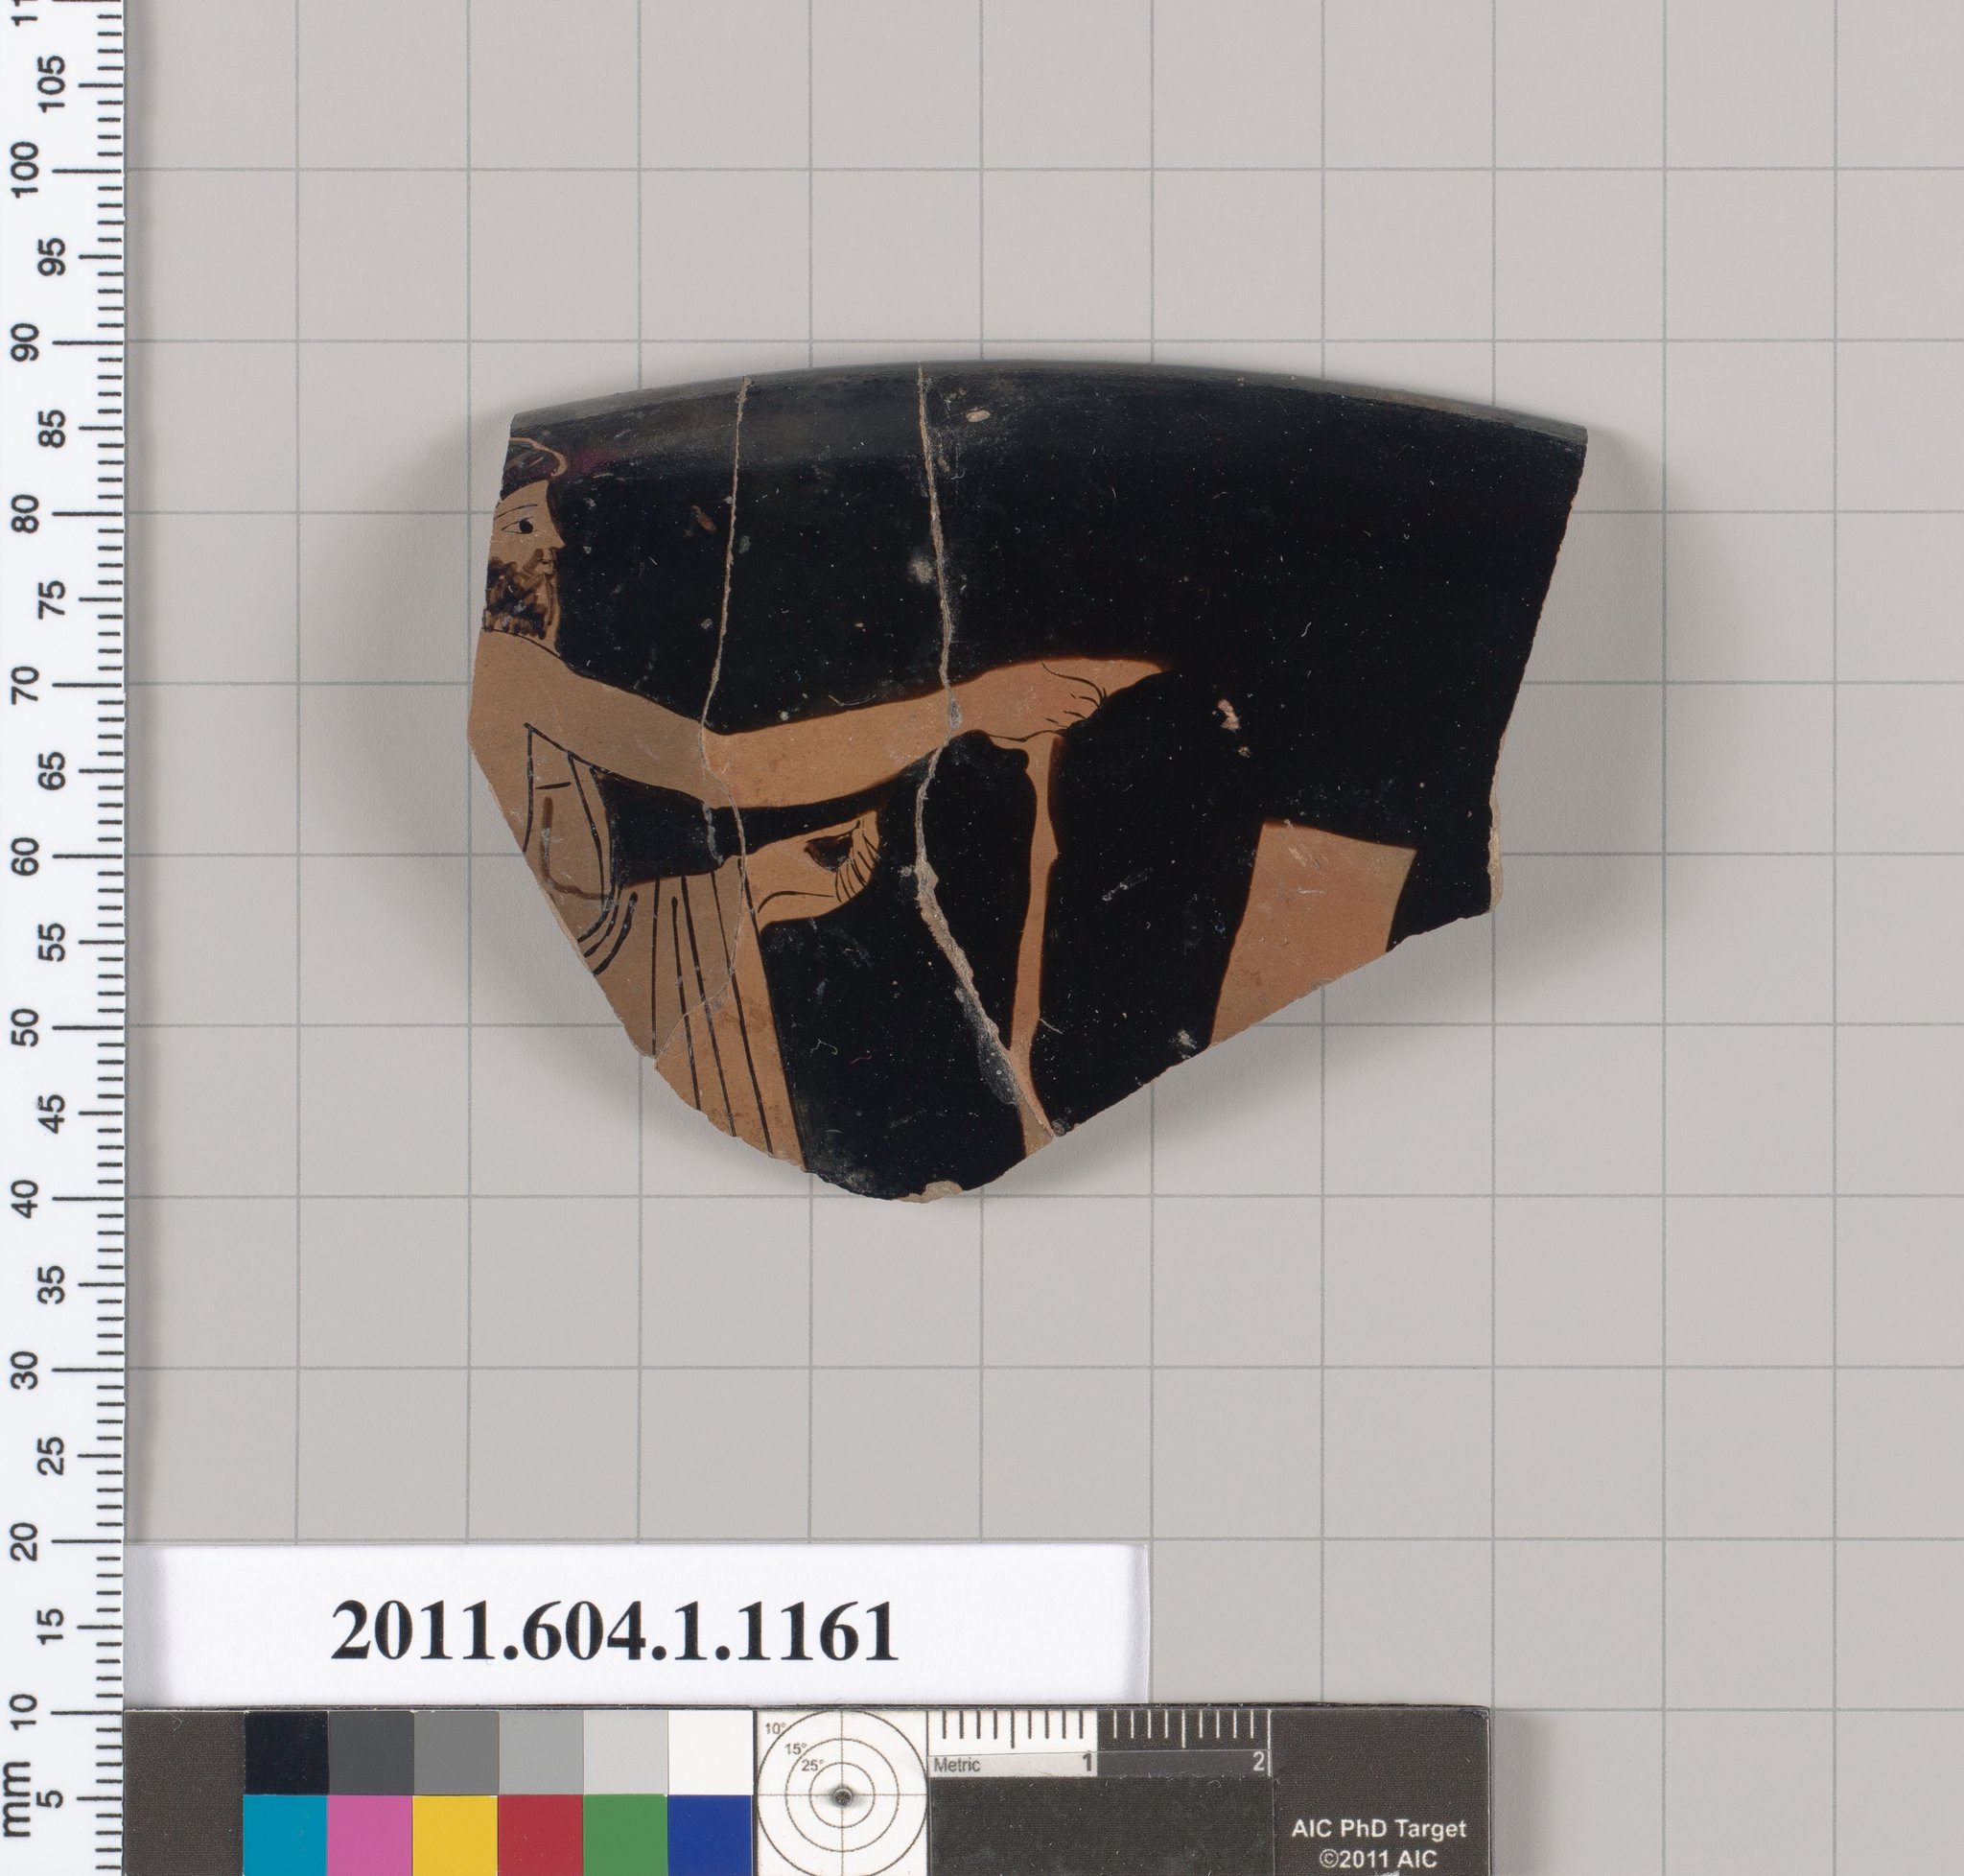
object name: kylix fragment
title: Terracotta rim fragment of a kylix (drinking cup)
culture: greek, attic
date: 475-451 BCE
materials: terracotta